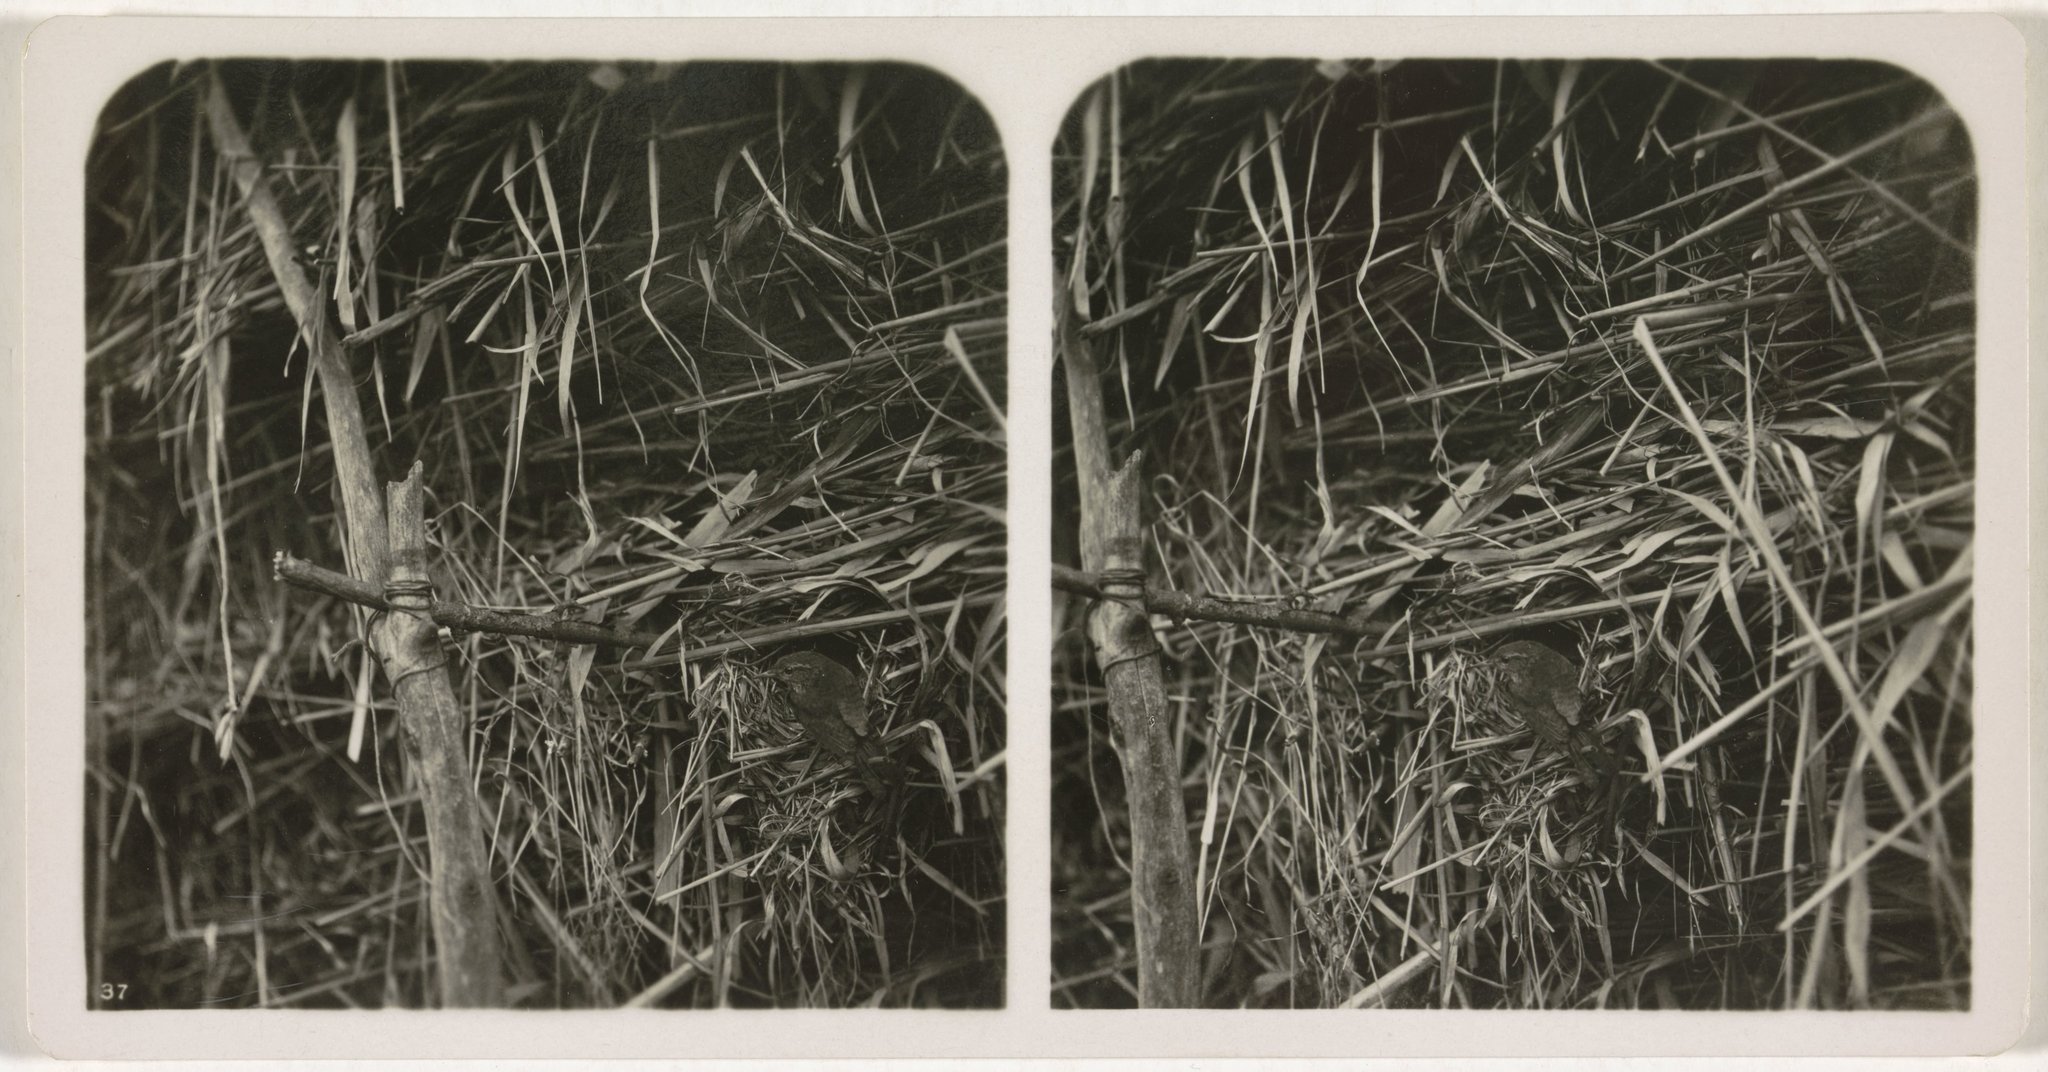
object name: stereograph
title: Les oiseaux et leurs nids / 2e Série Les oiseaux chanteurs (Suite).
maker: adolphe burdet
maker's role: fotograaf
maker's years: 1860-1940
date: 1870-1940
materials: photographic support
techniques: gelatin silver print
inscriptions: label: ‘37 / Troglodytes parvulus Koch / Troglodyte / Winterkoning...’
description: Linksonder op de foto links staat het nummer 37. Uit serie van 25 stereofoto's.